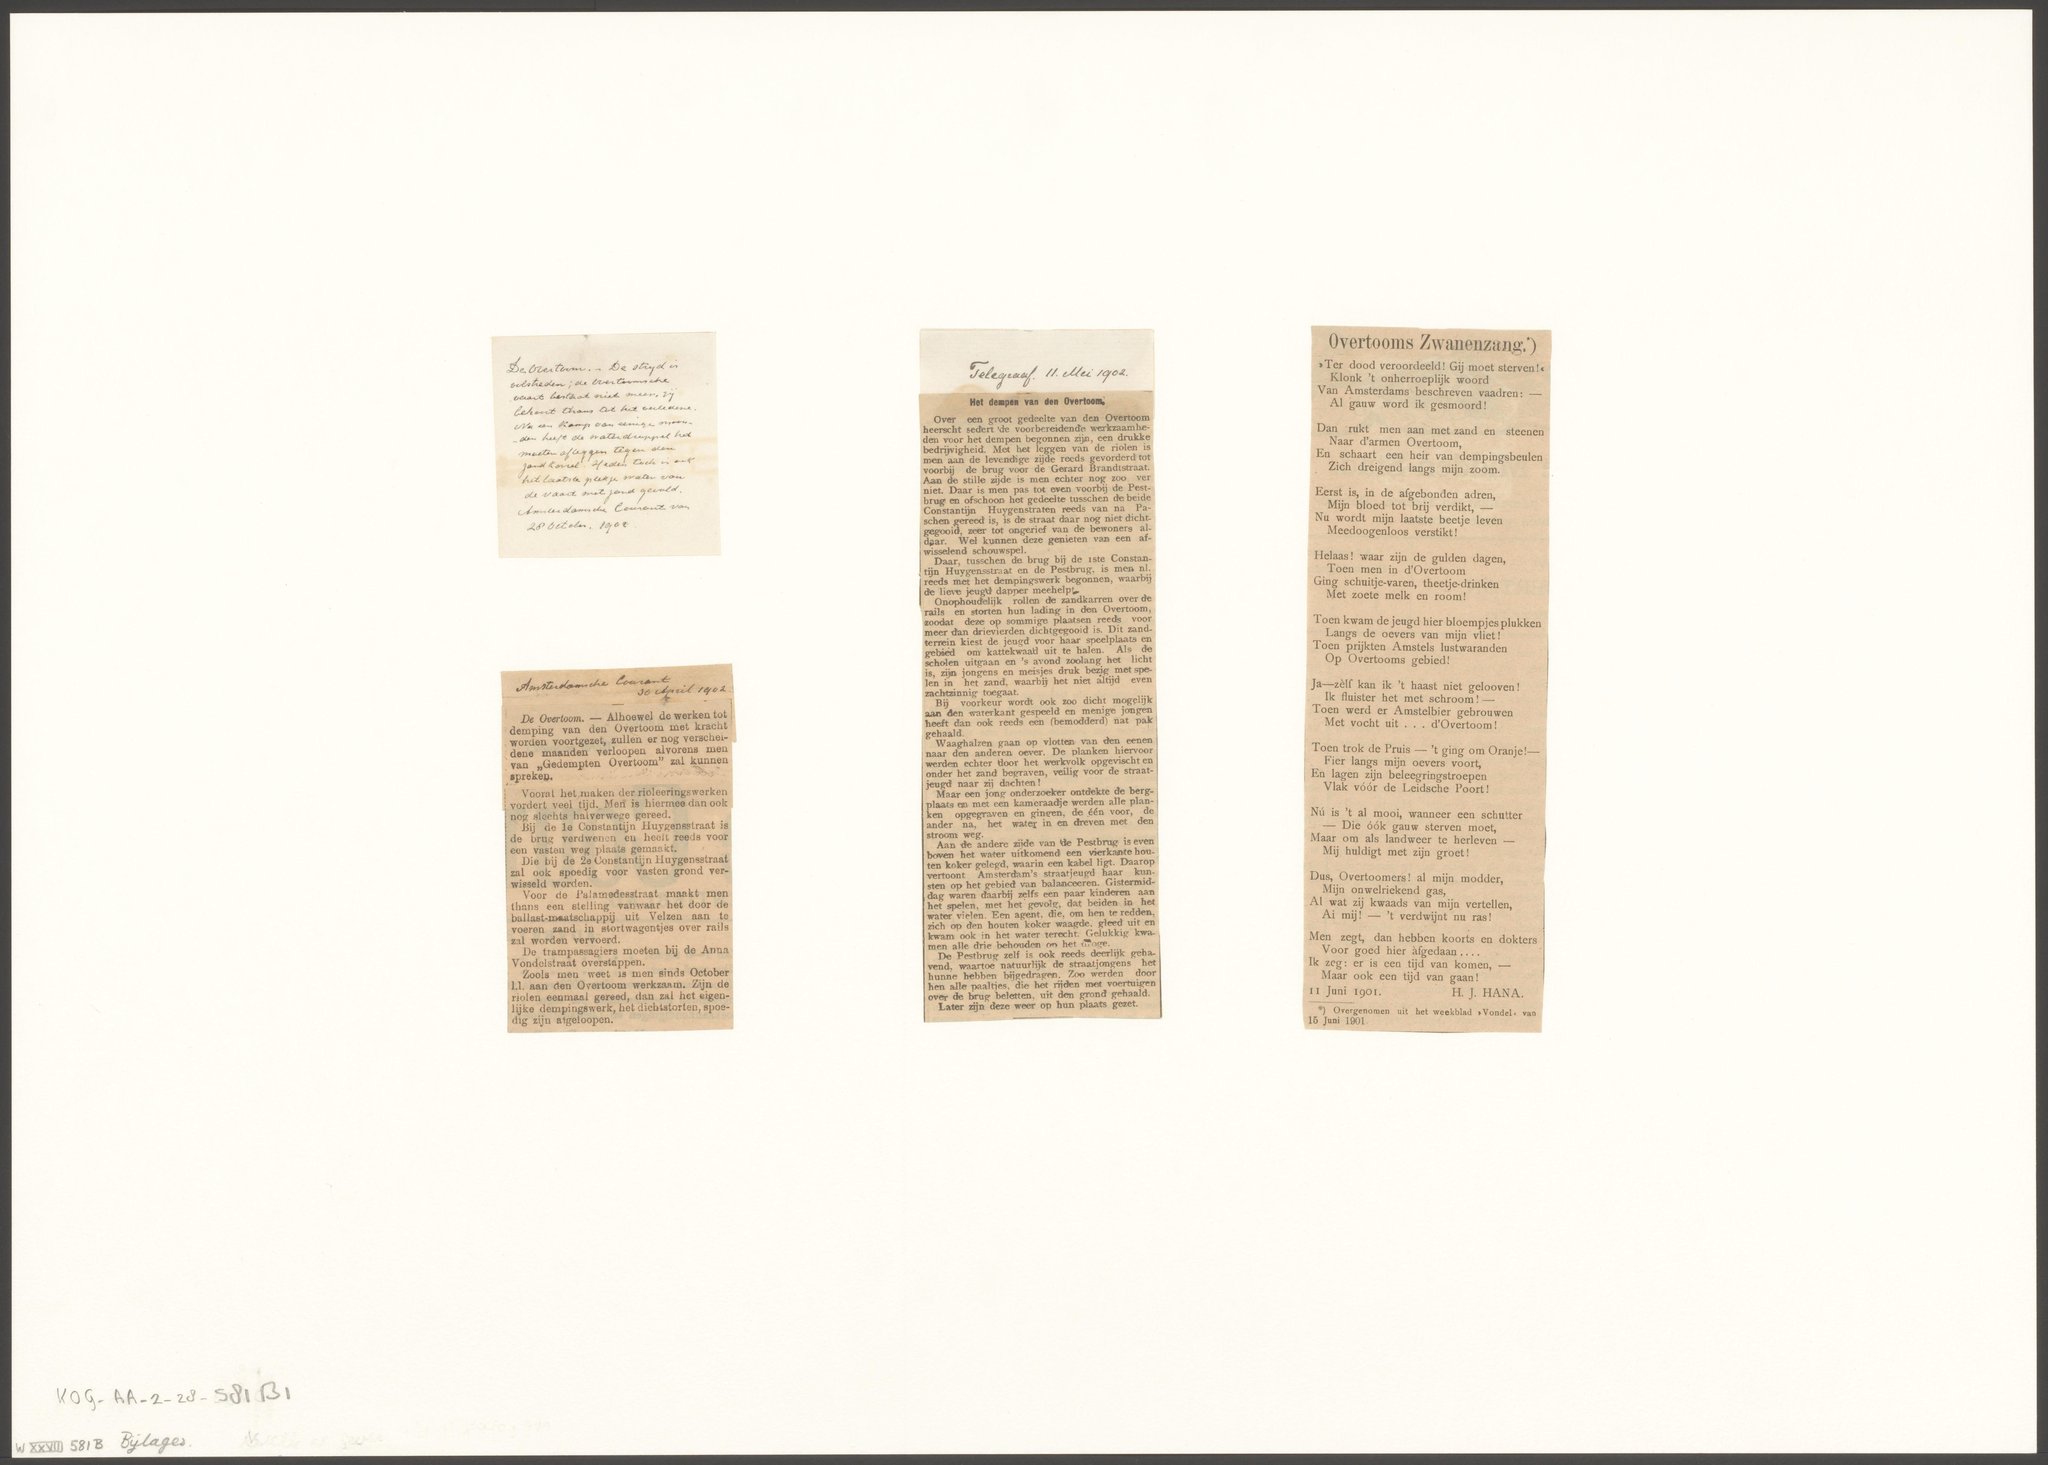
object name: tekst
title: Tekst en krantenknipsels naar aanleiding van de demping van de Overtoom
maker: Anonymous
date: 1902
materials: ink, paper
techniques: letterpress printing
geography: amsterdam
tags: handwriting, written text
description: Objecten binnen de Atlas Van Eck ingedeeld op wijknummer 28.